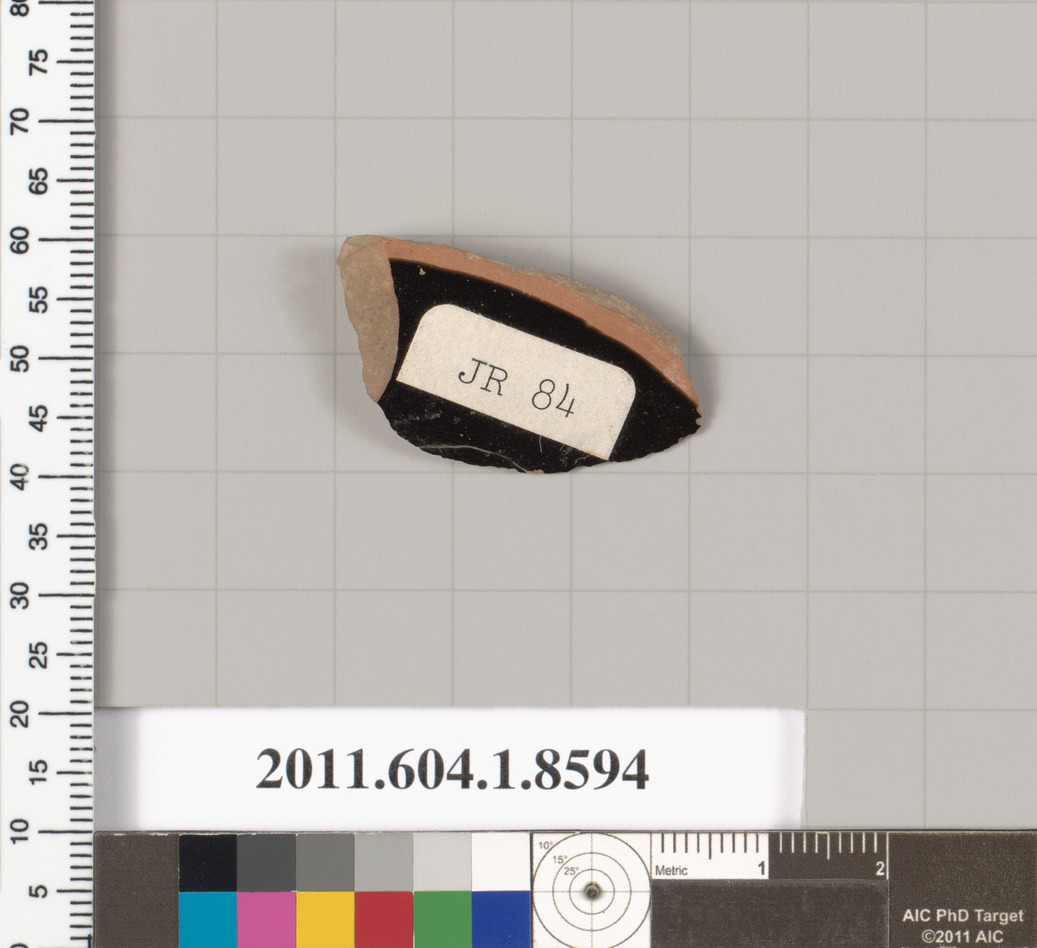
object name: kylix fragment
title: Terracotta fragment of a stemless kylix (drinking cup)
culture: greek, attic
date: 470-450 BCE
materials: terracotta